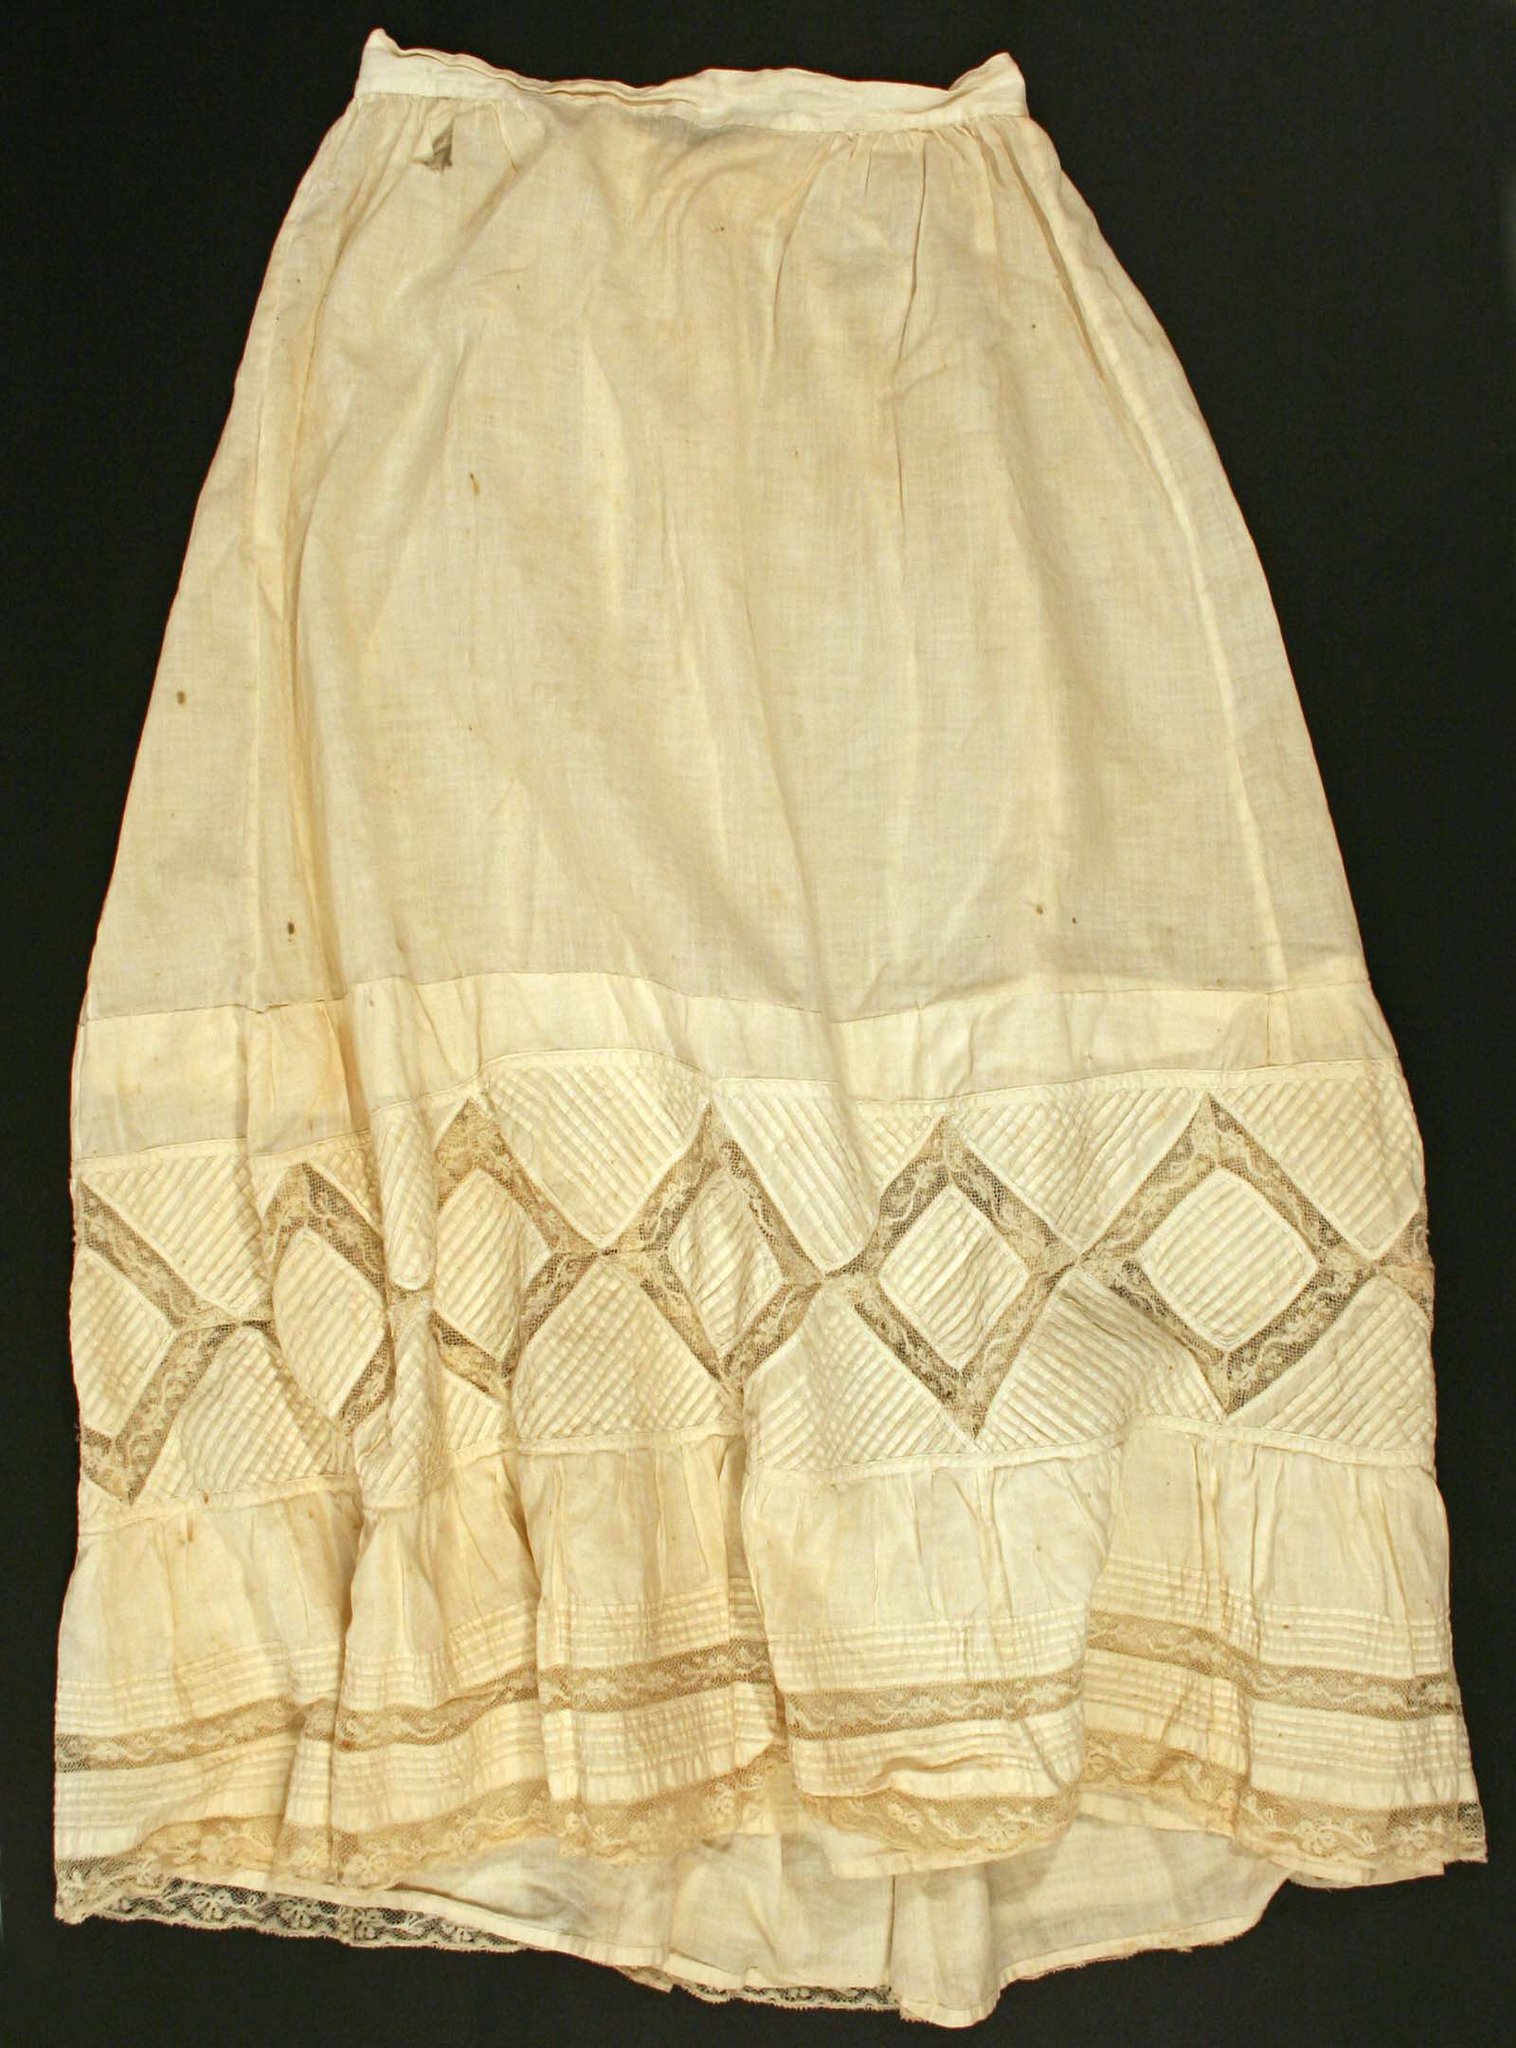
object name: underskirt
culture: american or european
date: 1879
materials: cotton